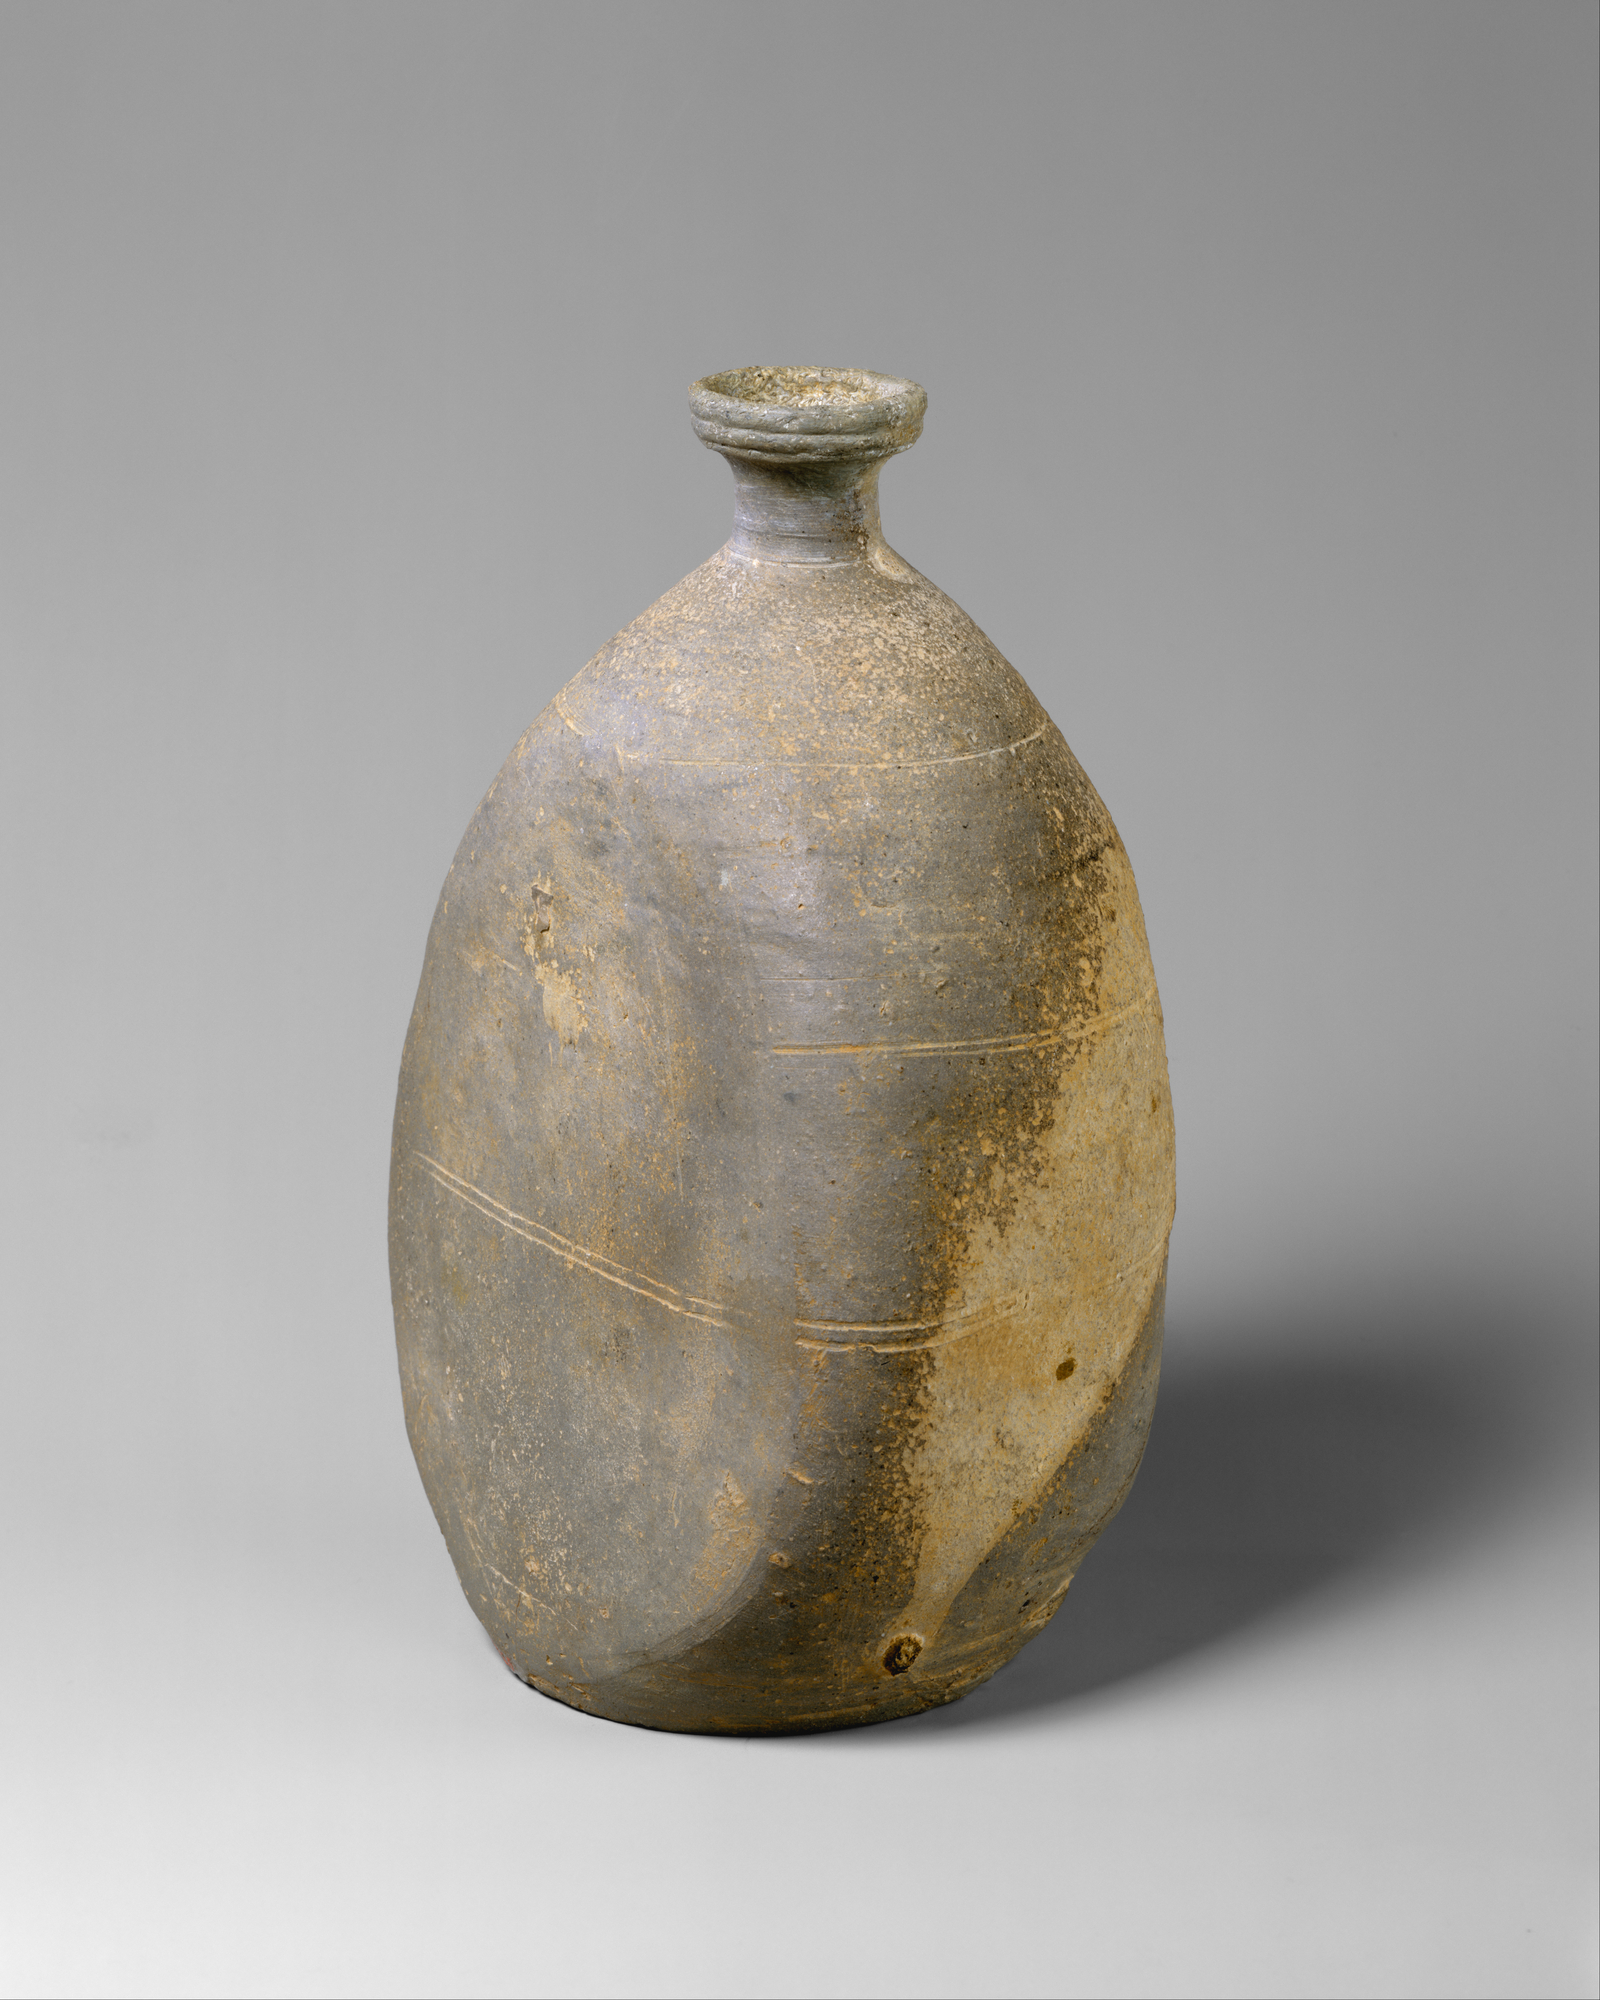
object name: bottle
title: Bottle with flattened side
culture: korean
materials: wood, glaze, stoneware